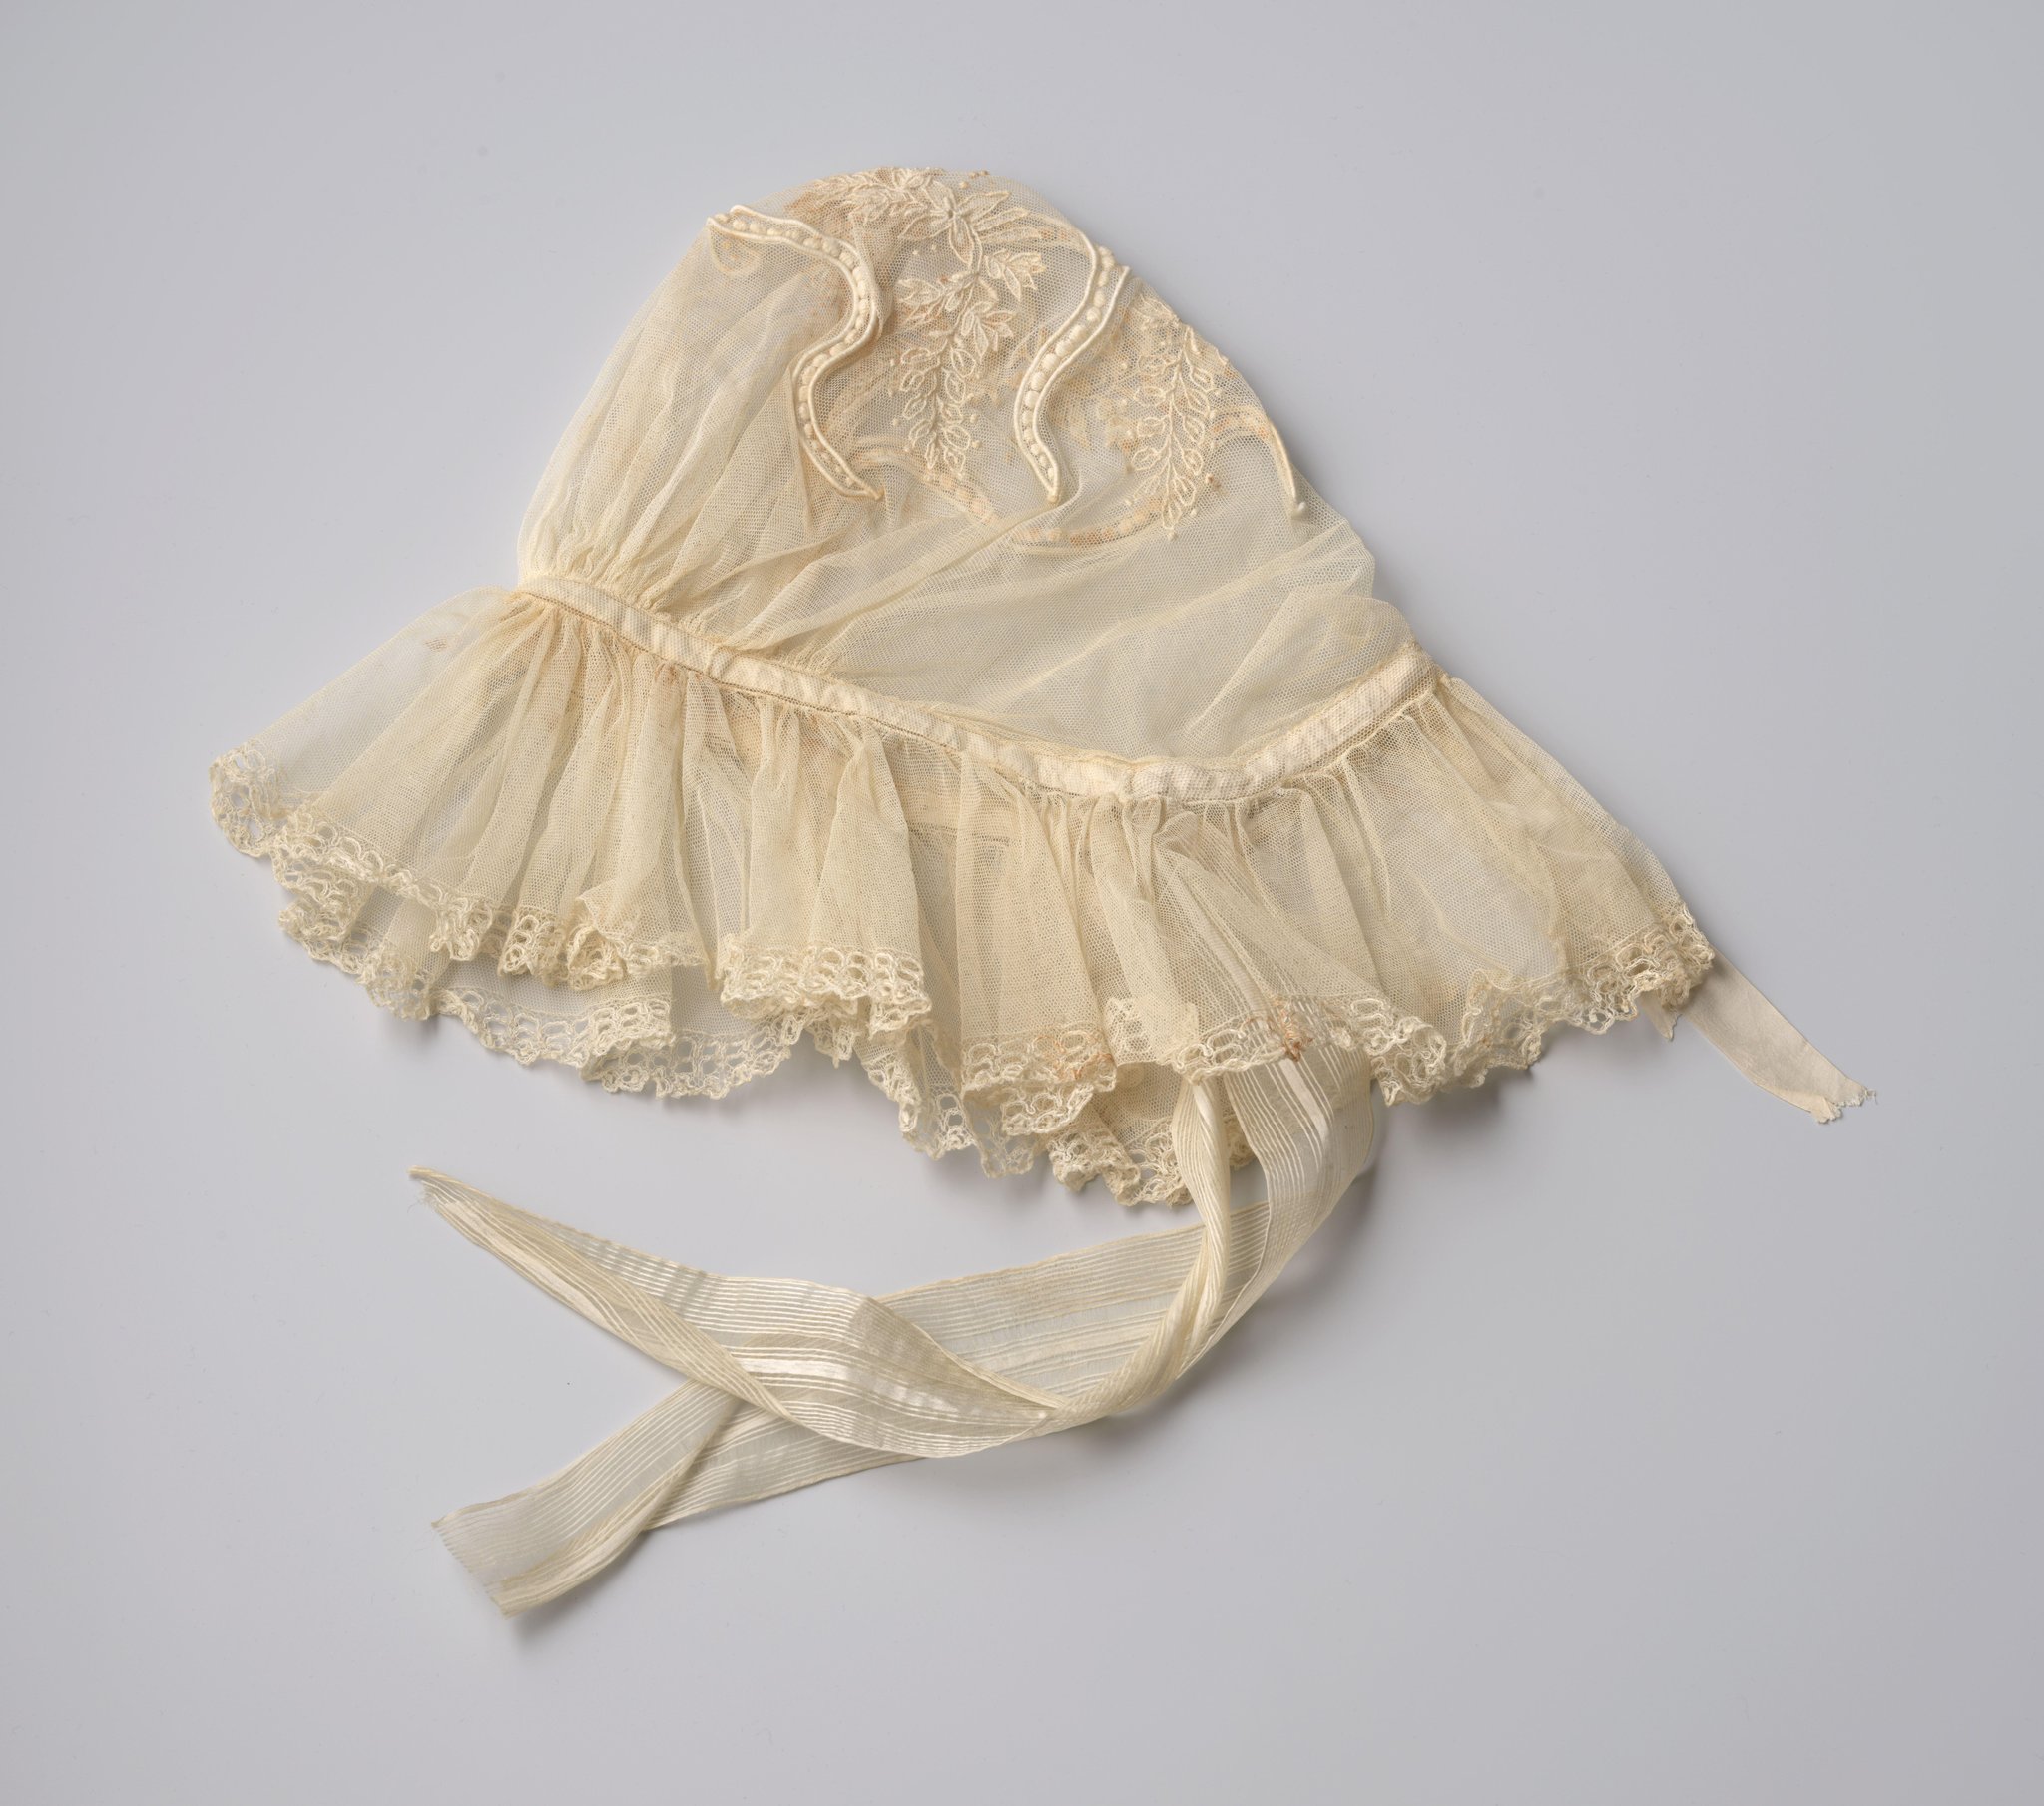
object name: womenswear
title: Muts van machinale tule versierd met doorstopwerk en applicaties, en afgezet met een strook Rijsselse kant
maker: Anonymous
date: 1830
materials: ribbon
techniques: lace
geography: netherlands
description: Muts van machinale tule. Op de bol zijn twee takken geborduurd en geapplicceerd tussen drie geborduurde golfmotieven. De bol is gedeeltelijk gerimpeld aan de voorhoofdband gezet. Aan de voorhoofdstrook is een strook gezet, die is afgezet met een strook Rijsselse kant. De muts heeft een schuiflint en twee linten die dienen als kinnebanden.